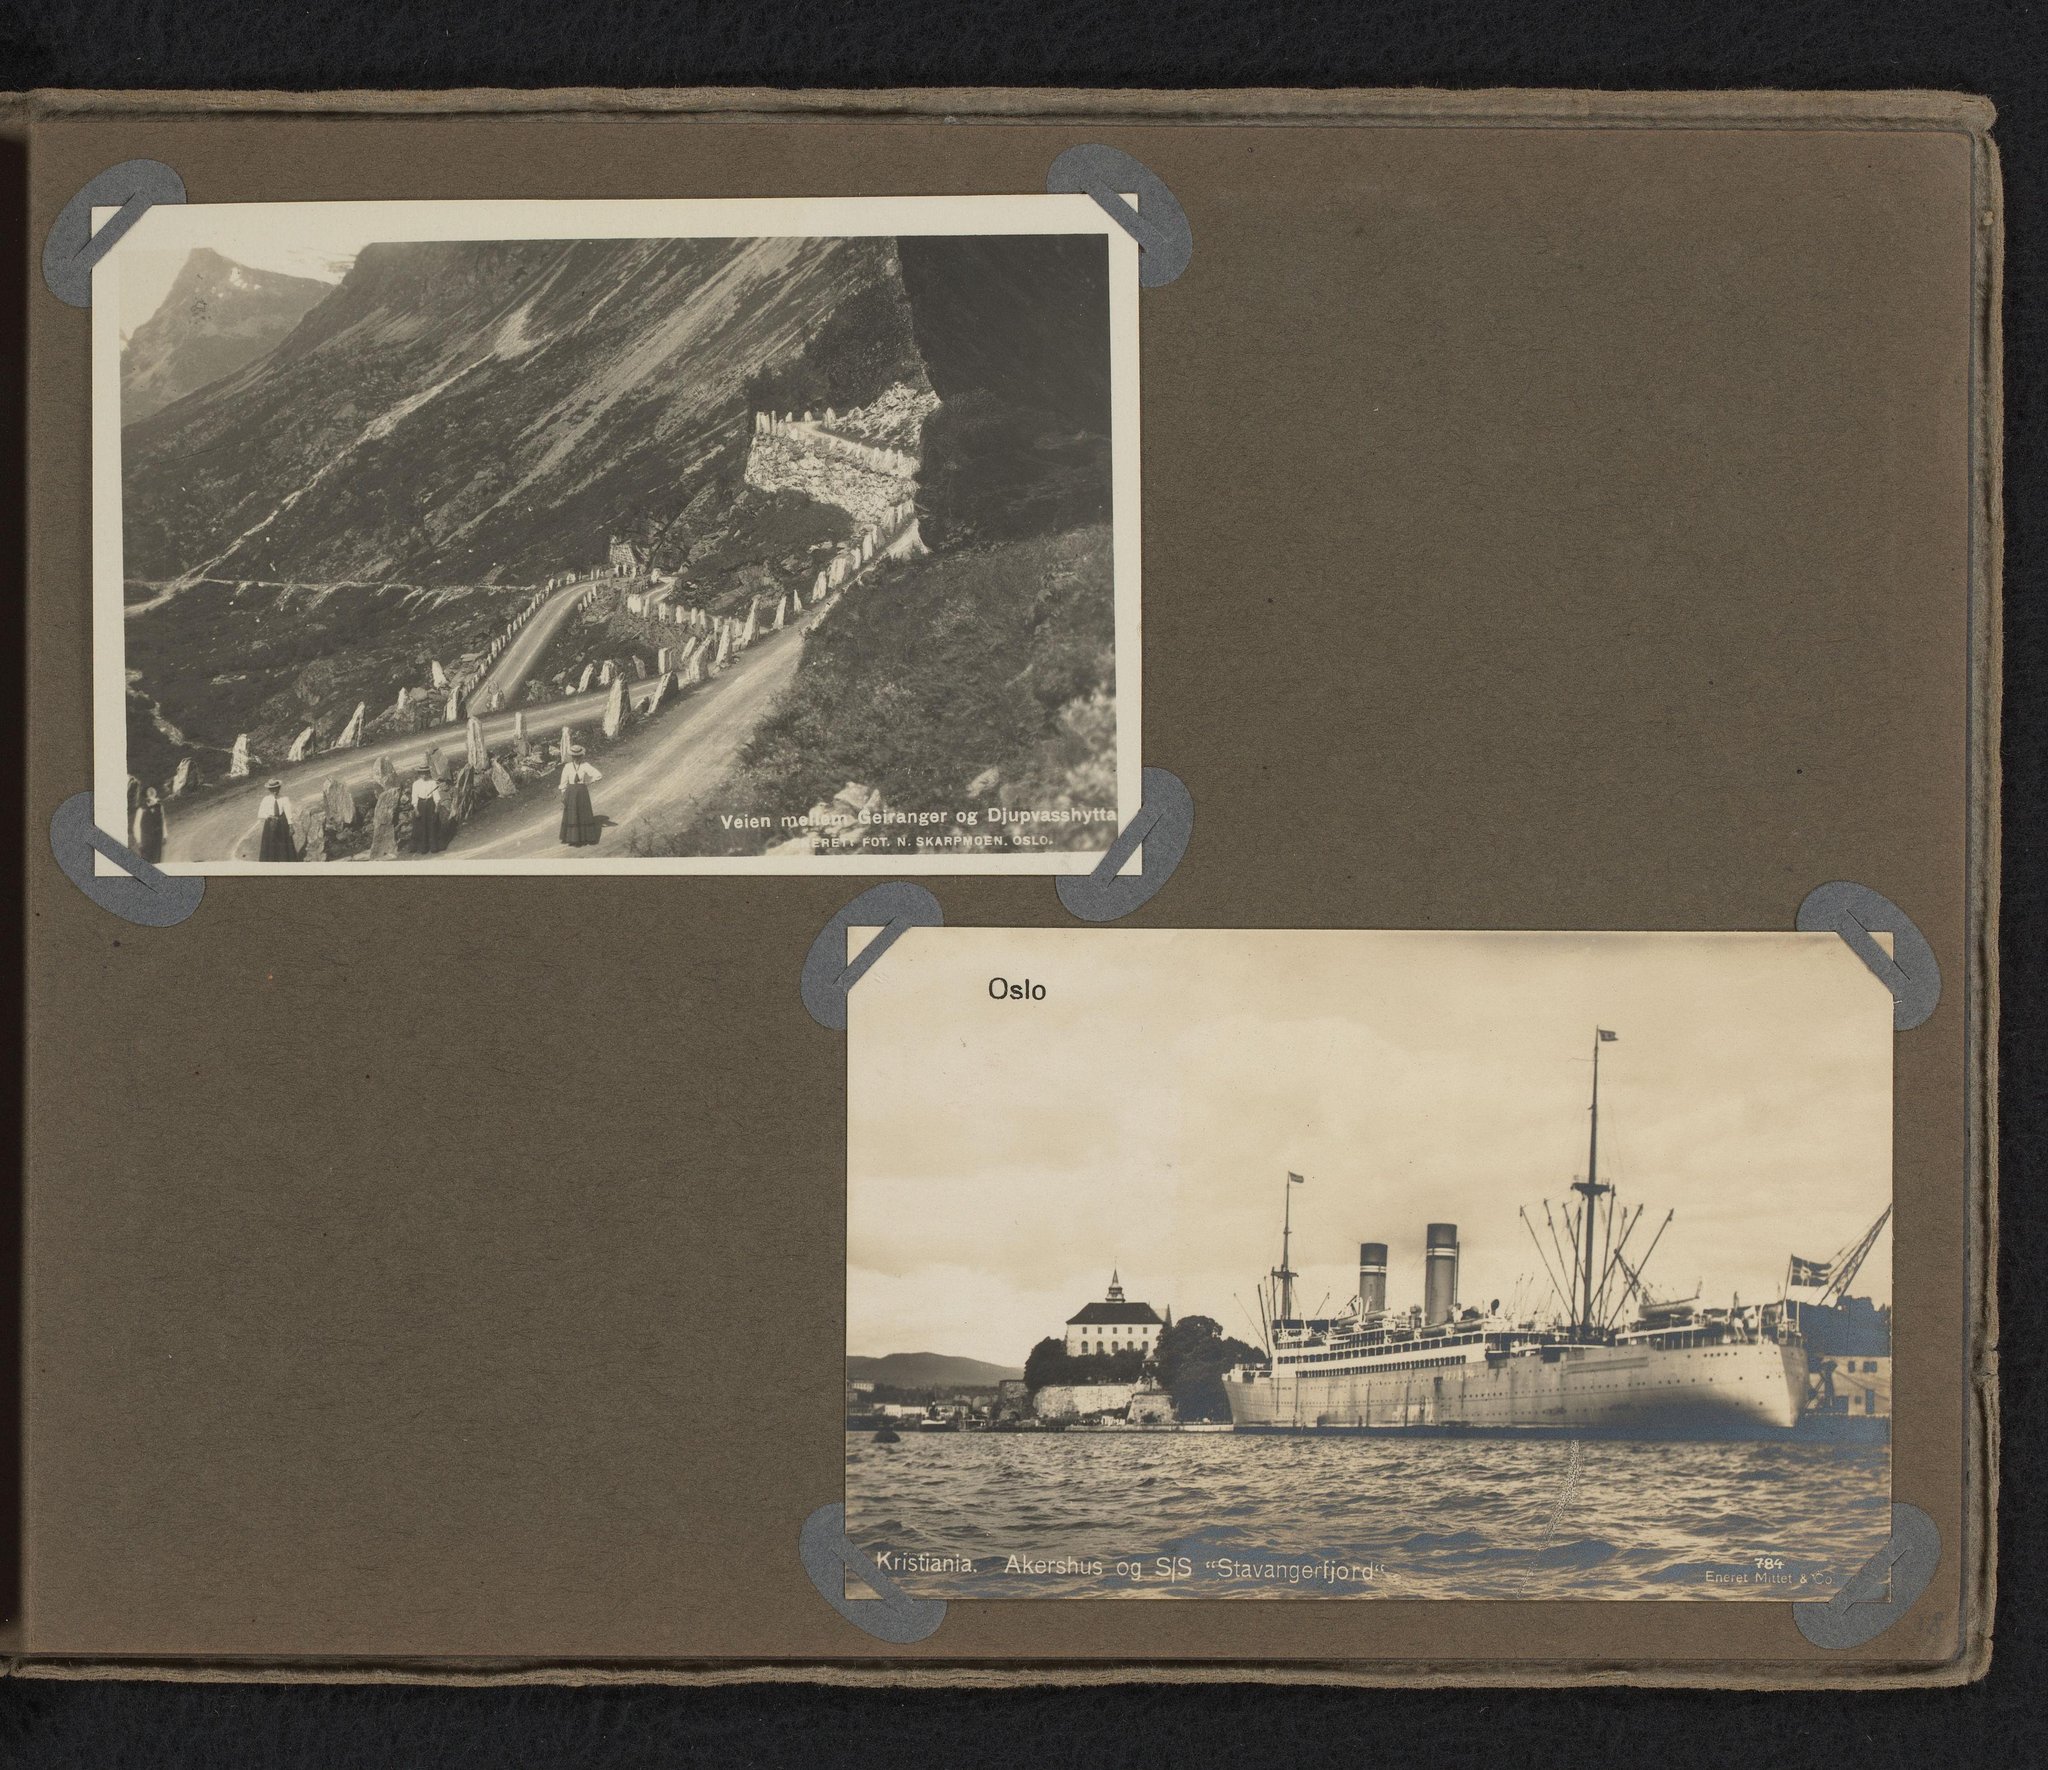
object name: photograph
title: Twee prentbriefkaarten van Noorwegen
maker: narve skarpmoen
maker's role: fotograaf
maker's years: 1868-1930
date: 1927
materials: paper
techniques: gelatin silver print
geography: norway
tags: steamship, motorship, mountains, norway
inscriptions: inscription: ‘Veien mellem Geiranger og Djupvasshytta’, inscription: ‘Oslo/ Kristiania. Akershus og S/S "Stavangerfjord"’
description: Deze foto's maken deel uit van een album.